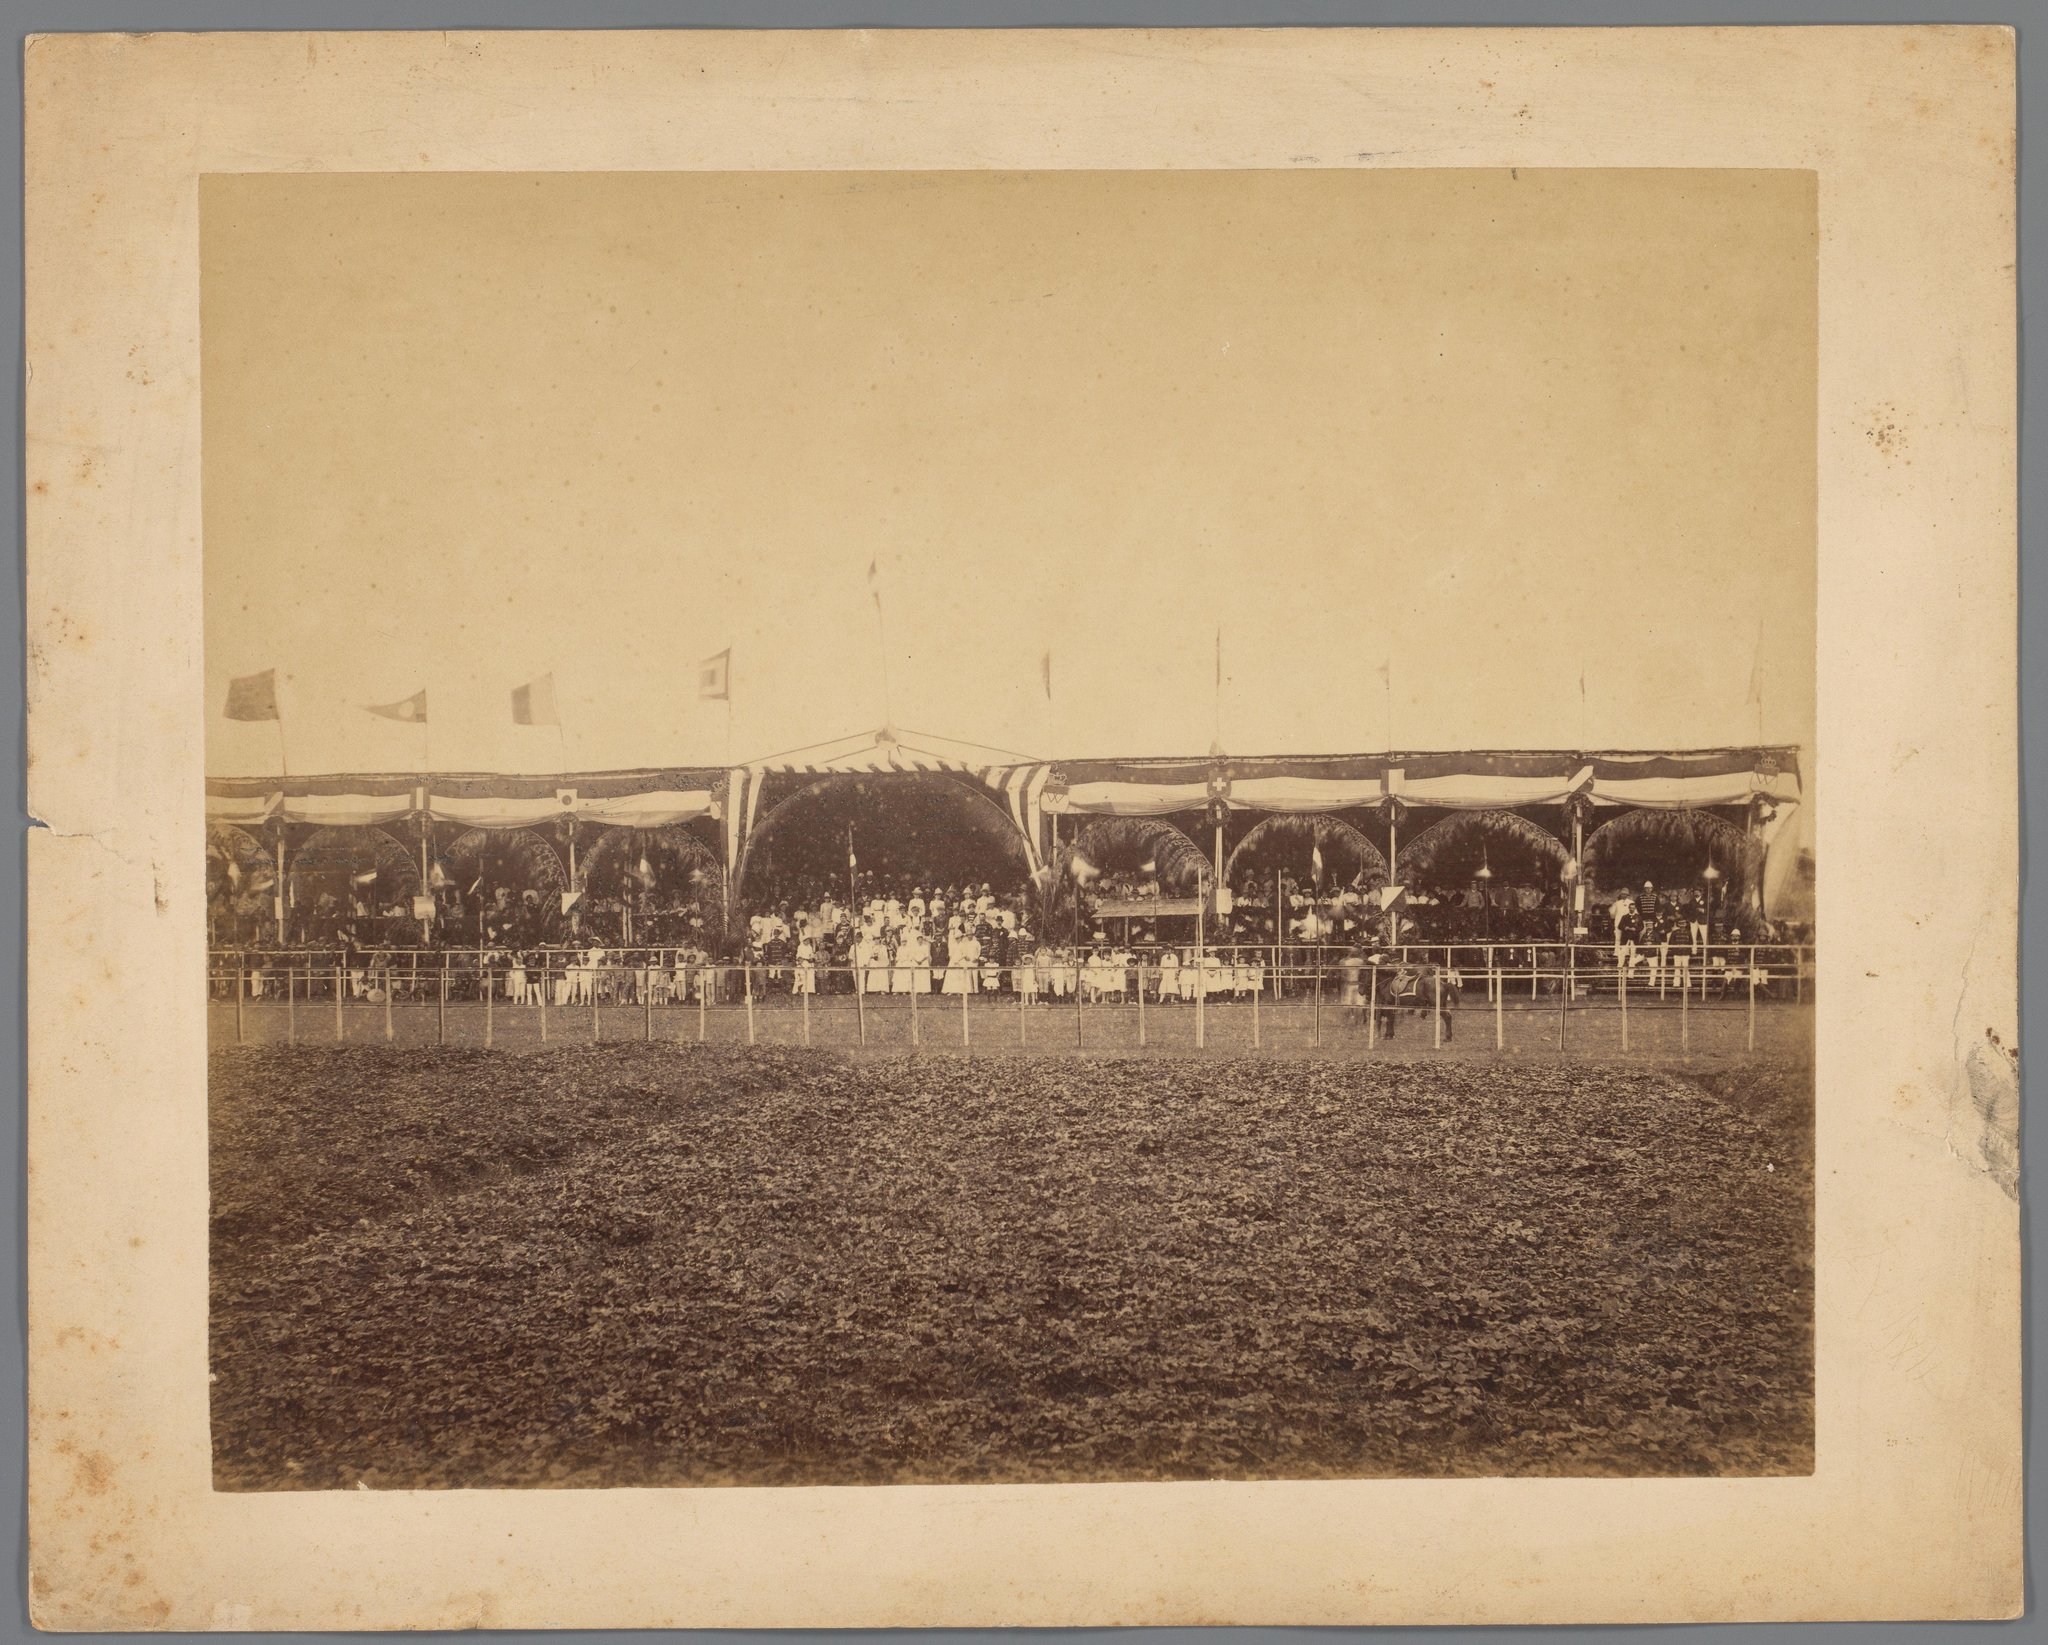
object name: photograph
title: Tribune van een paardenrenbaan in Nederlands-Indië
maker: Anonymous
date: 1860-1880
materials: cardboard, paper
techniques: albumen print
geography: dutch east indies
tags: race-track, dutch east indies, the